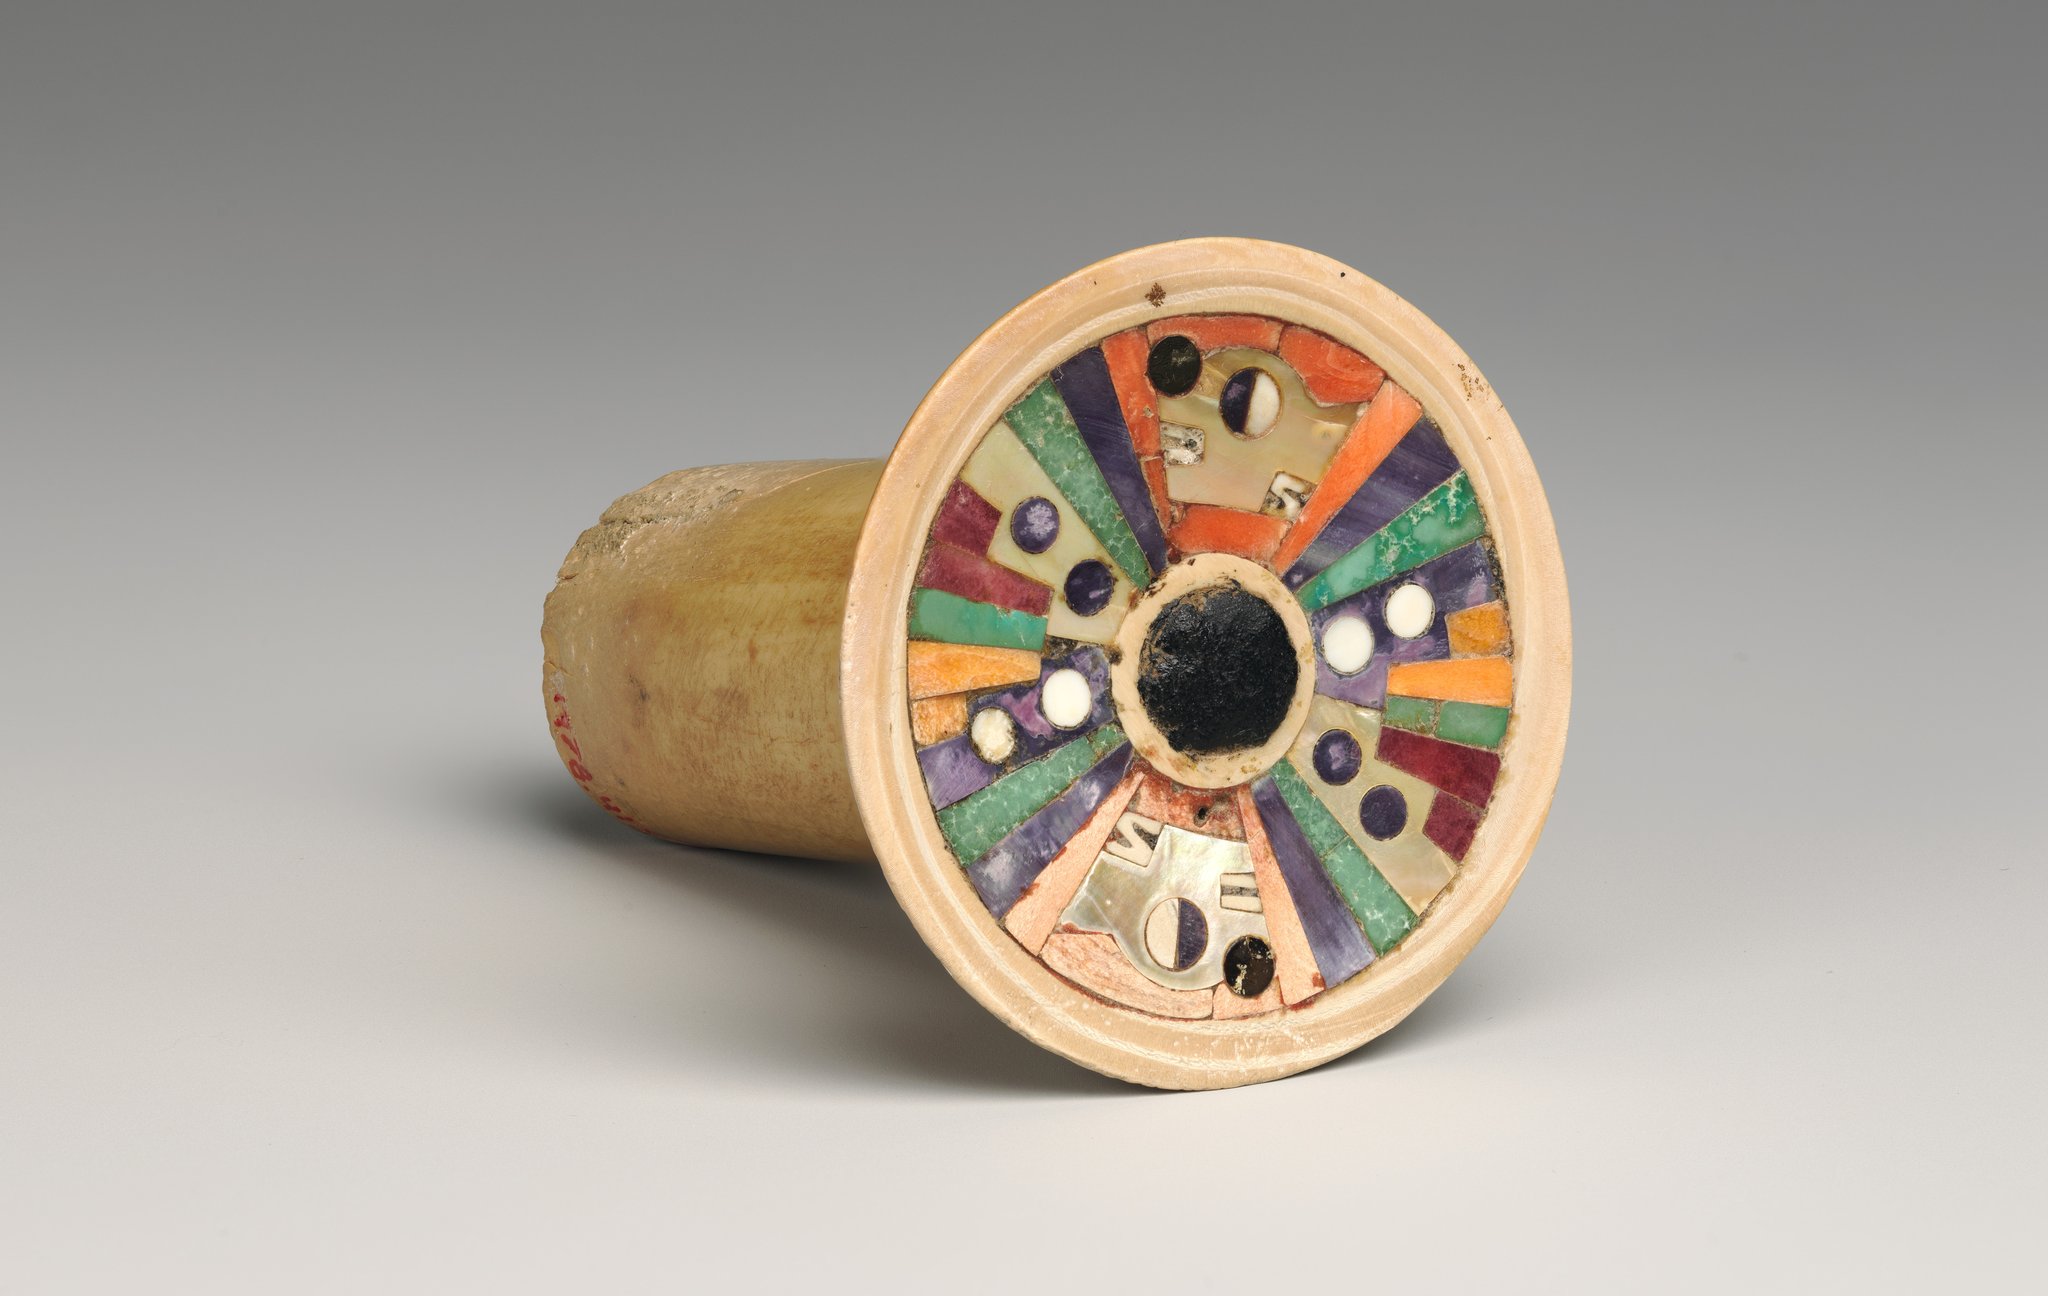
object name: earflare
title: Ear ornament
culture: wari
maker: wari artist(s)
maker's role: artist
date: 650-1000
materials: bone, shell, stone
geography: peru